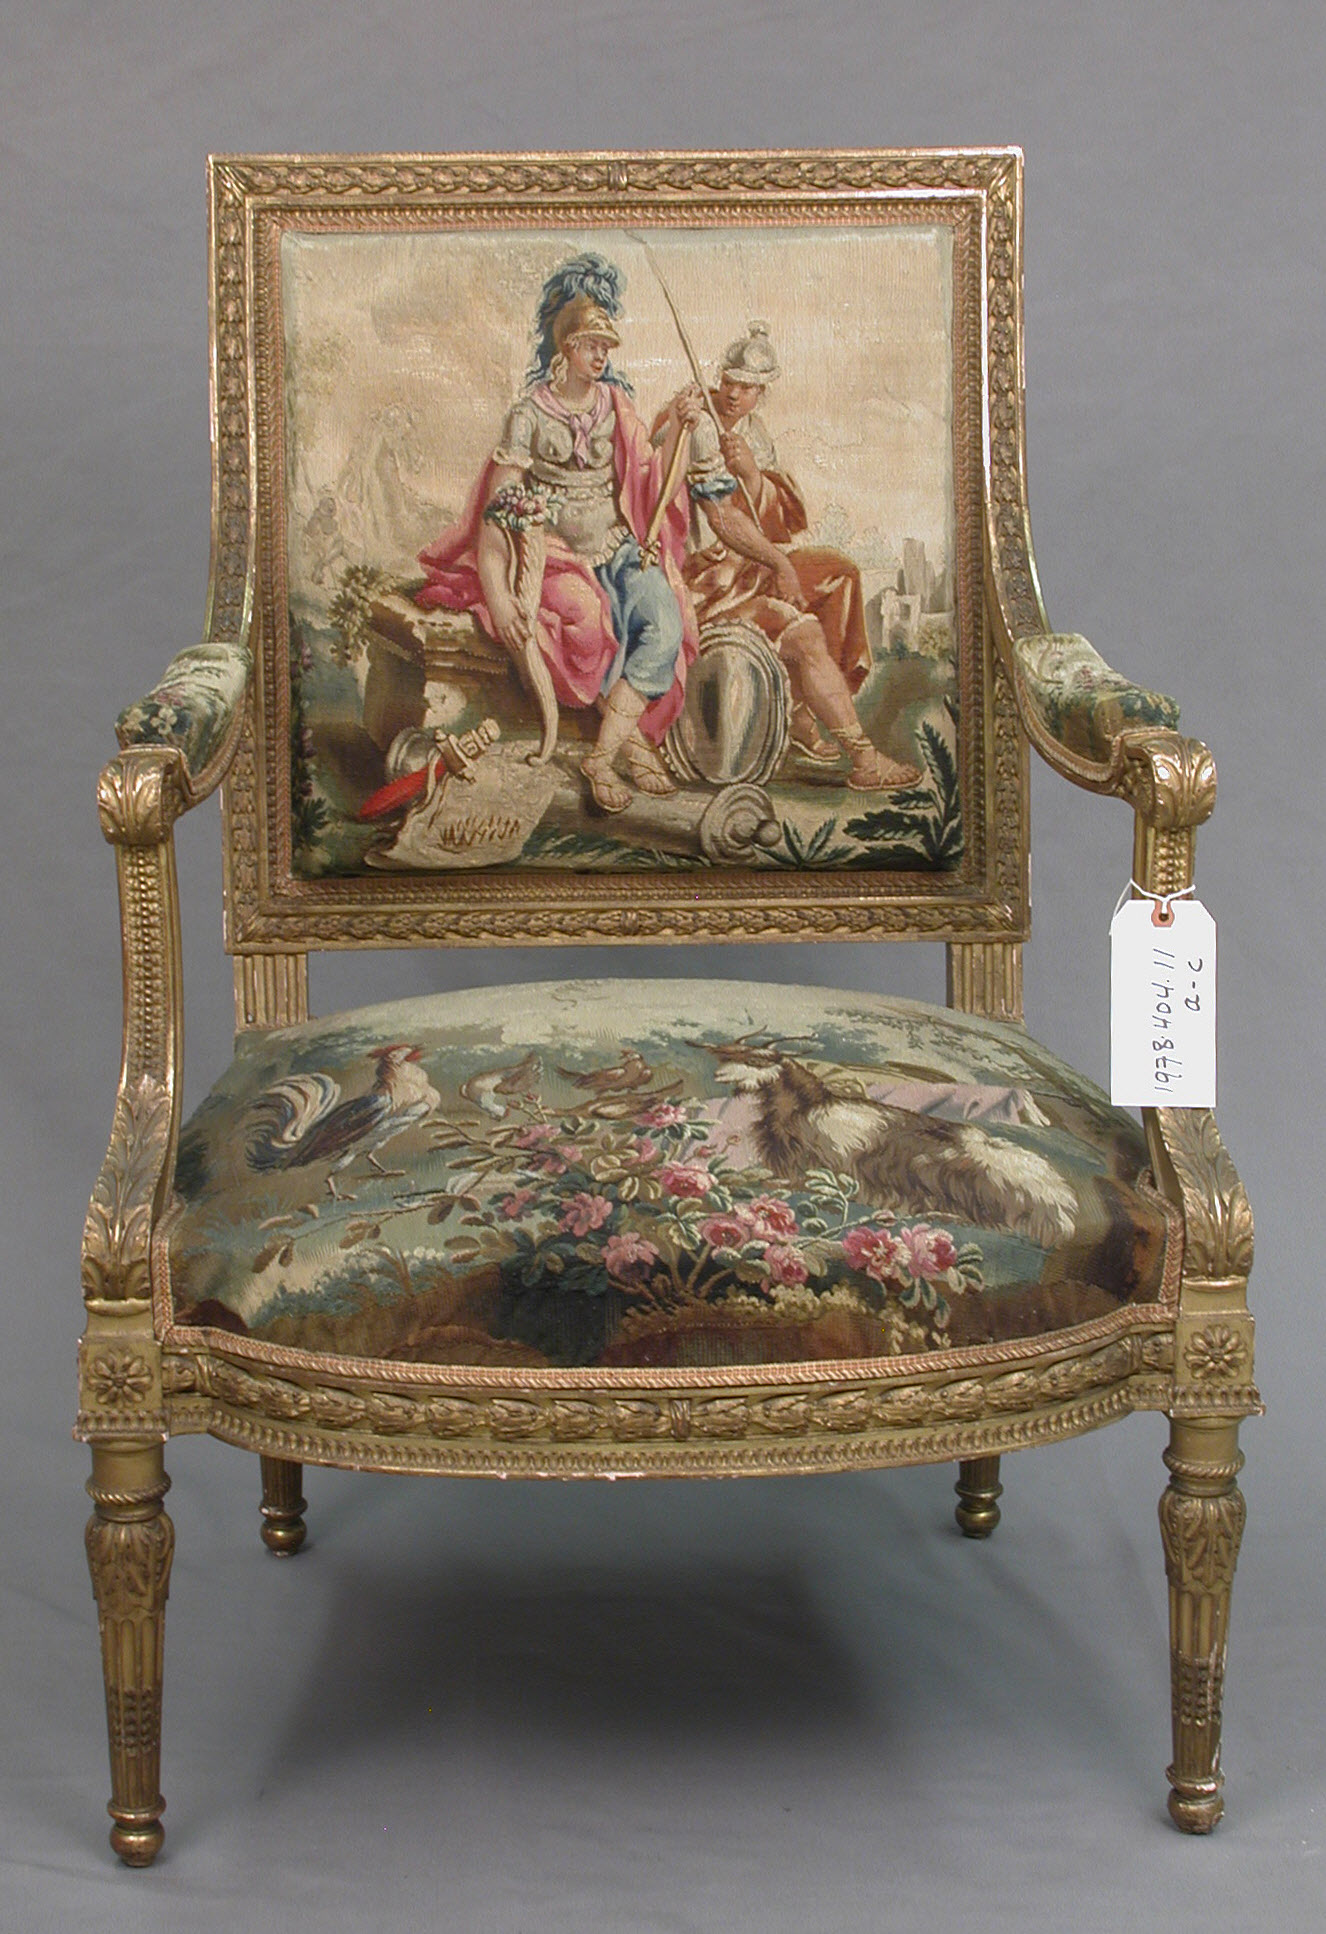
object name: armchair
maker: beauvais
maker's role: manufactory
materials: silk, wood, wool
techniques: carving, gilding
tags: chickens,men,women,goats,flowers